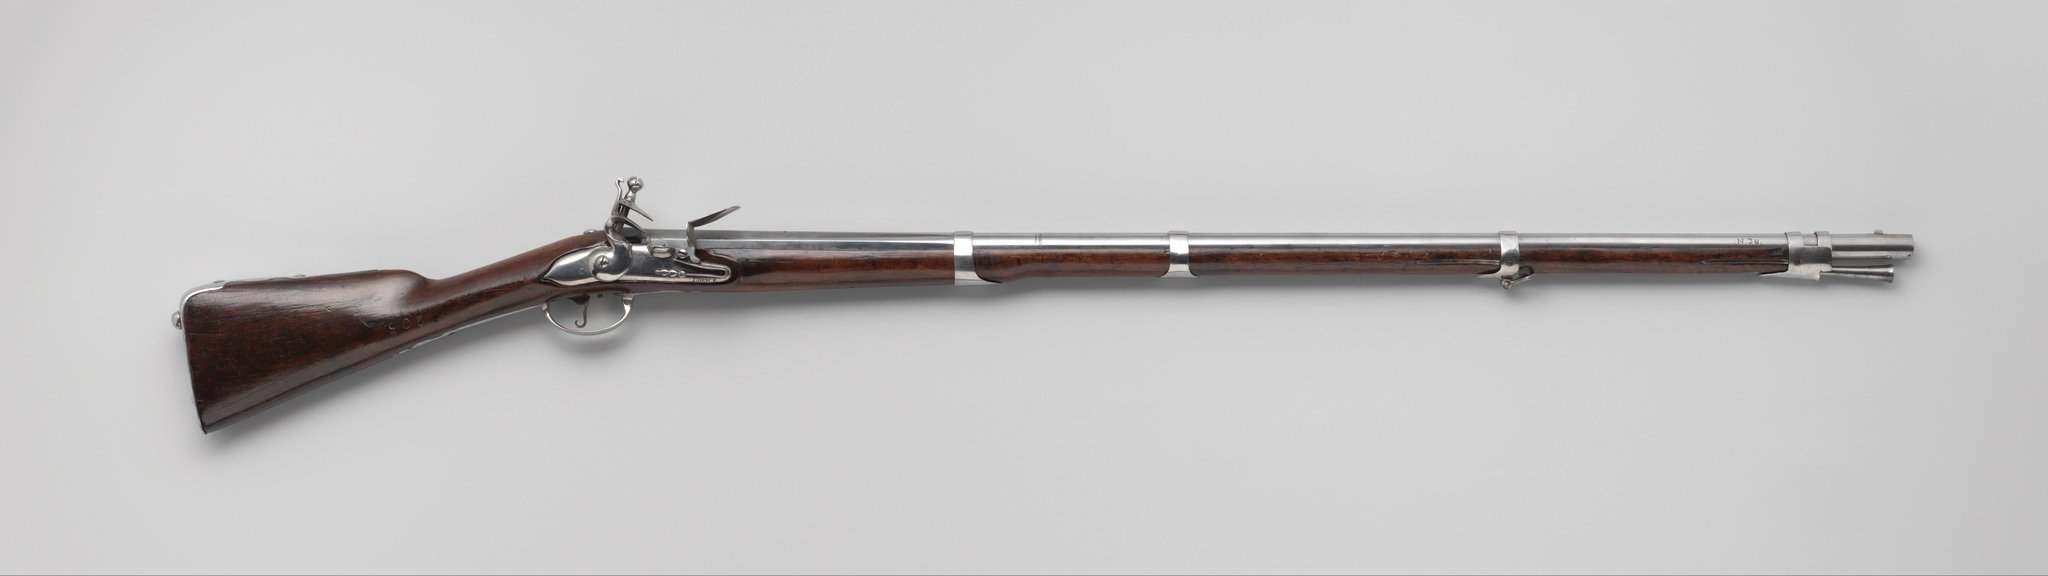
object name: flintlock pistol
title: Vuursteengeweer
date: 1710-1780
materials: iron, steel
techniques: printing, cutting, engraving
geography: liège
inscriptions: initials: ‘203; HC of HG’, : ‘K.N.63.G.’, signature: ‘I.BEHR’, mark: ‘N; HID (cf. St. 7528); N.38’